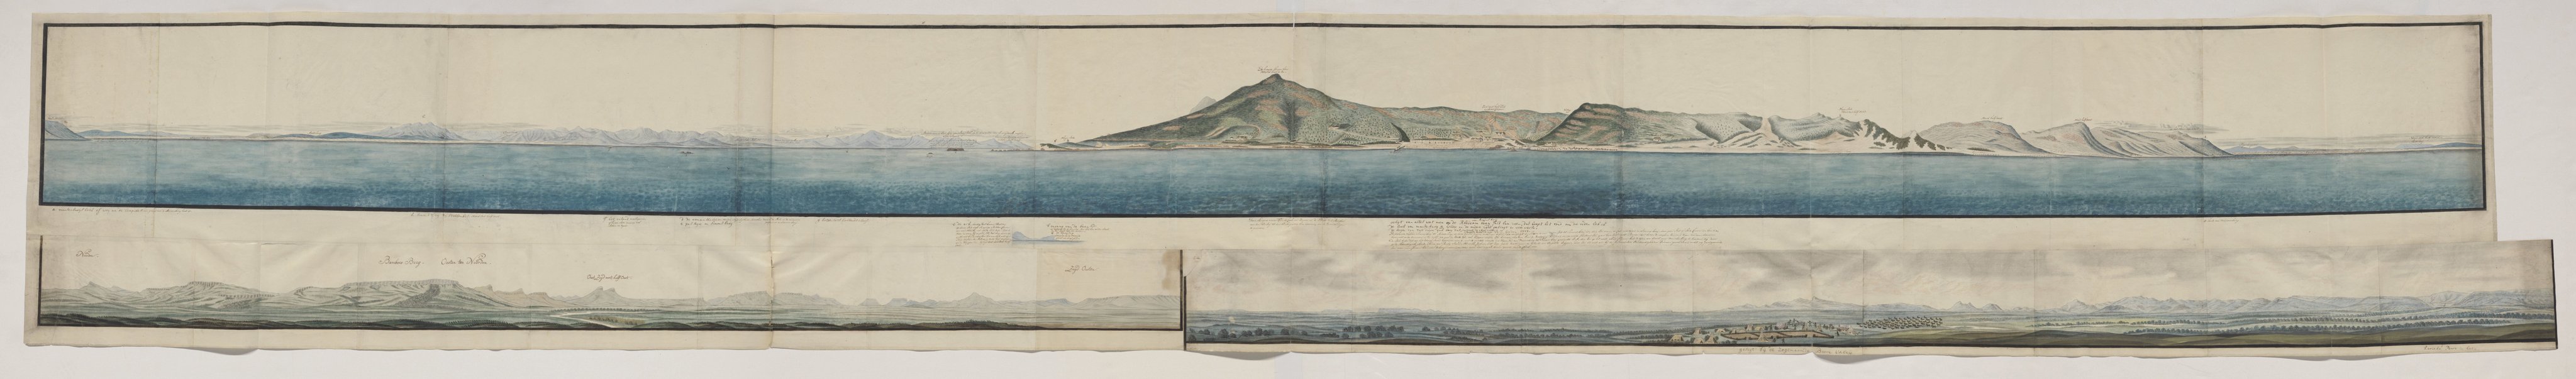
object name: panorama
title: Panorama of Beervlei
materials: ink, paper, pencil, watercolor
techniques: brush, pen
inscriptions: annotation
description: Dit panorama toont het landschap bij Beervlei, noord van het huidige Willowmore, bij de Kariegarivier, een bovenloop van de Gamtoosrivier. Geheel rechts de 'poort' of doorgang door de bergen, waardoor de Kariega stroomt; met nr. 17 op één vel geplakt.